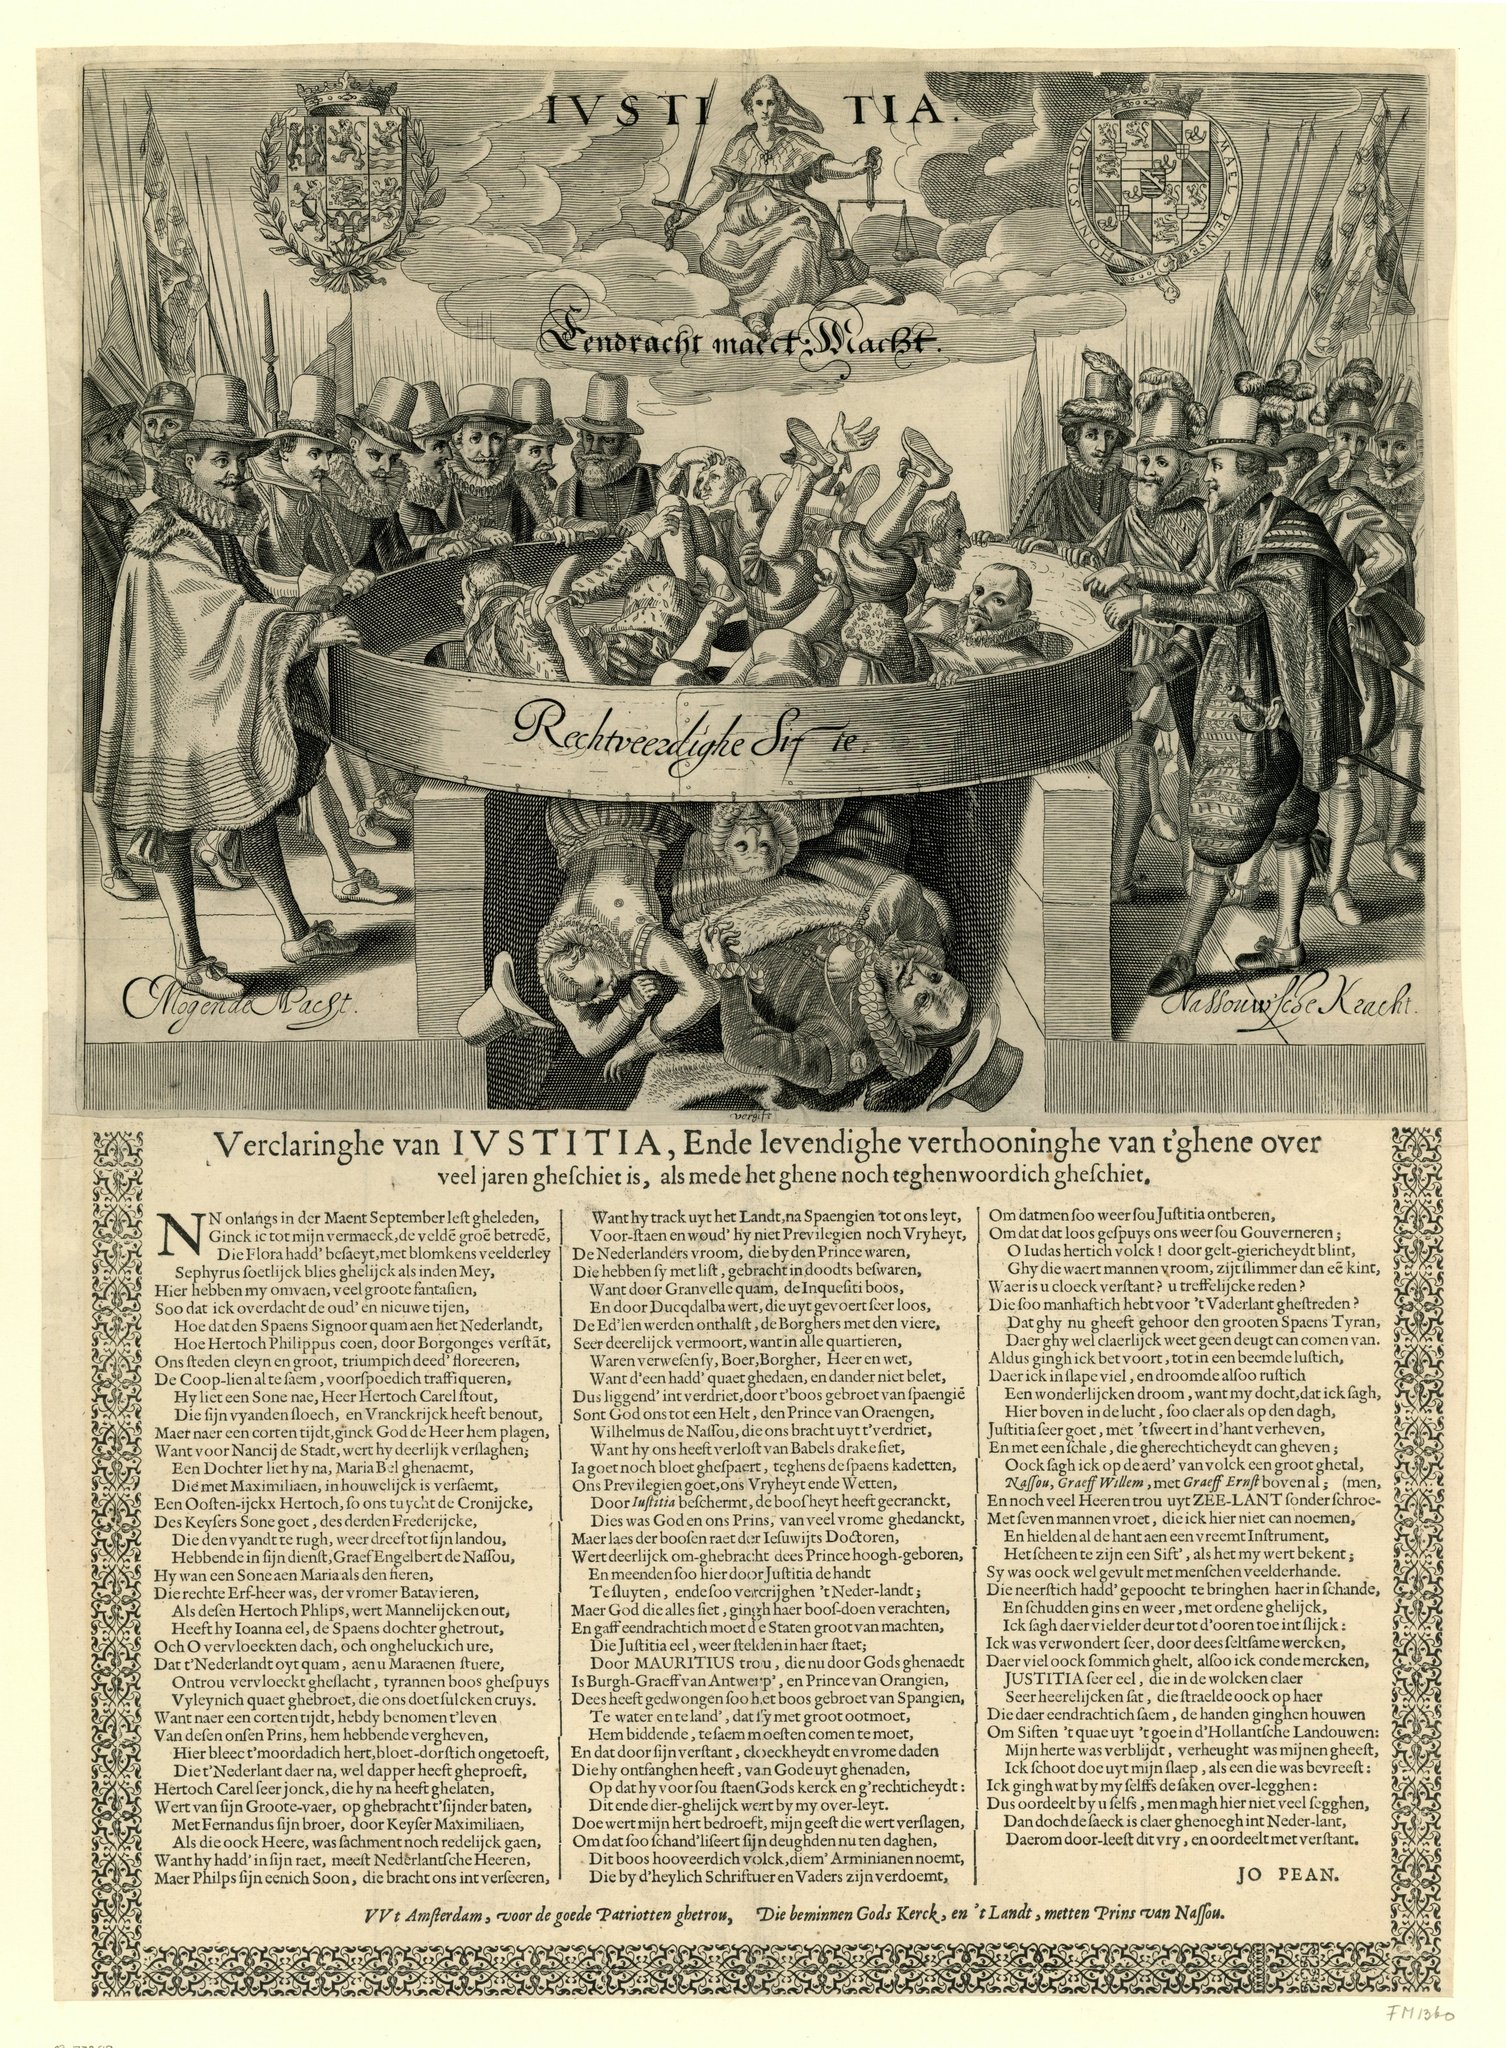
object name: cartoon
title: Rechtveerdighe Sifte, 1618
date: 1618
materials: paper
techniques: engraving, etching, letterpress printing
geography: amsterdam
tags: johan van oldenbarnevelt, the hague, maurice (prince of orange), willem lodewijk graaf van nassau-dillenburg, ernst casimir graaf van nassau-dietz, justice, 'justitia'; 'giustitia divina' (ripa) ~ one of the four cardinal virtues, sorting, selecting of material by sieving, sifting, screening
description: Spotprent op de val van Johan van Oldenbarnevelt. Rechts staan prins Maurits, graaf Willem Lodewijk en graaf Ernst Casimir, links leden van de Staten-Generaal aan een zeef waar Van Oldenbarnevelt en twee anderen, aangeduid als 'vergift', doorheen vallen. Boven Justitia en de wapens van Maurits en de Republiek der zeven verenigde provincies. Onder de voorstelling geplakt een tekstblad met een lange vers over drie kolommen met de titel 'Verclaringhe van IVSTITIA, Ende levendighe verthooninghe van t'ghene over veel jaren gheschiet is, als mede het ghene teghenwoordich gheschiet'. Het vers is gesigneerd 'Jo Pean'.